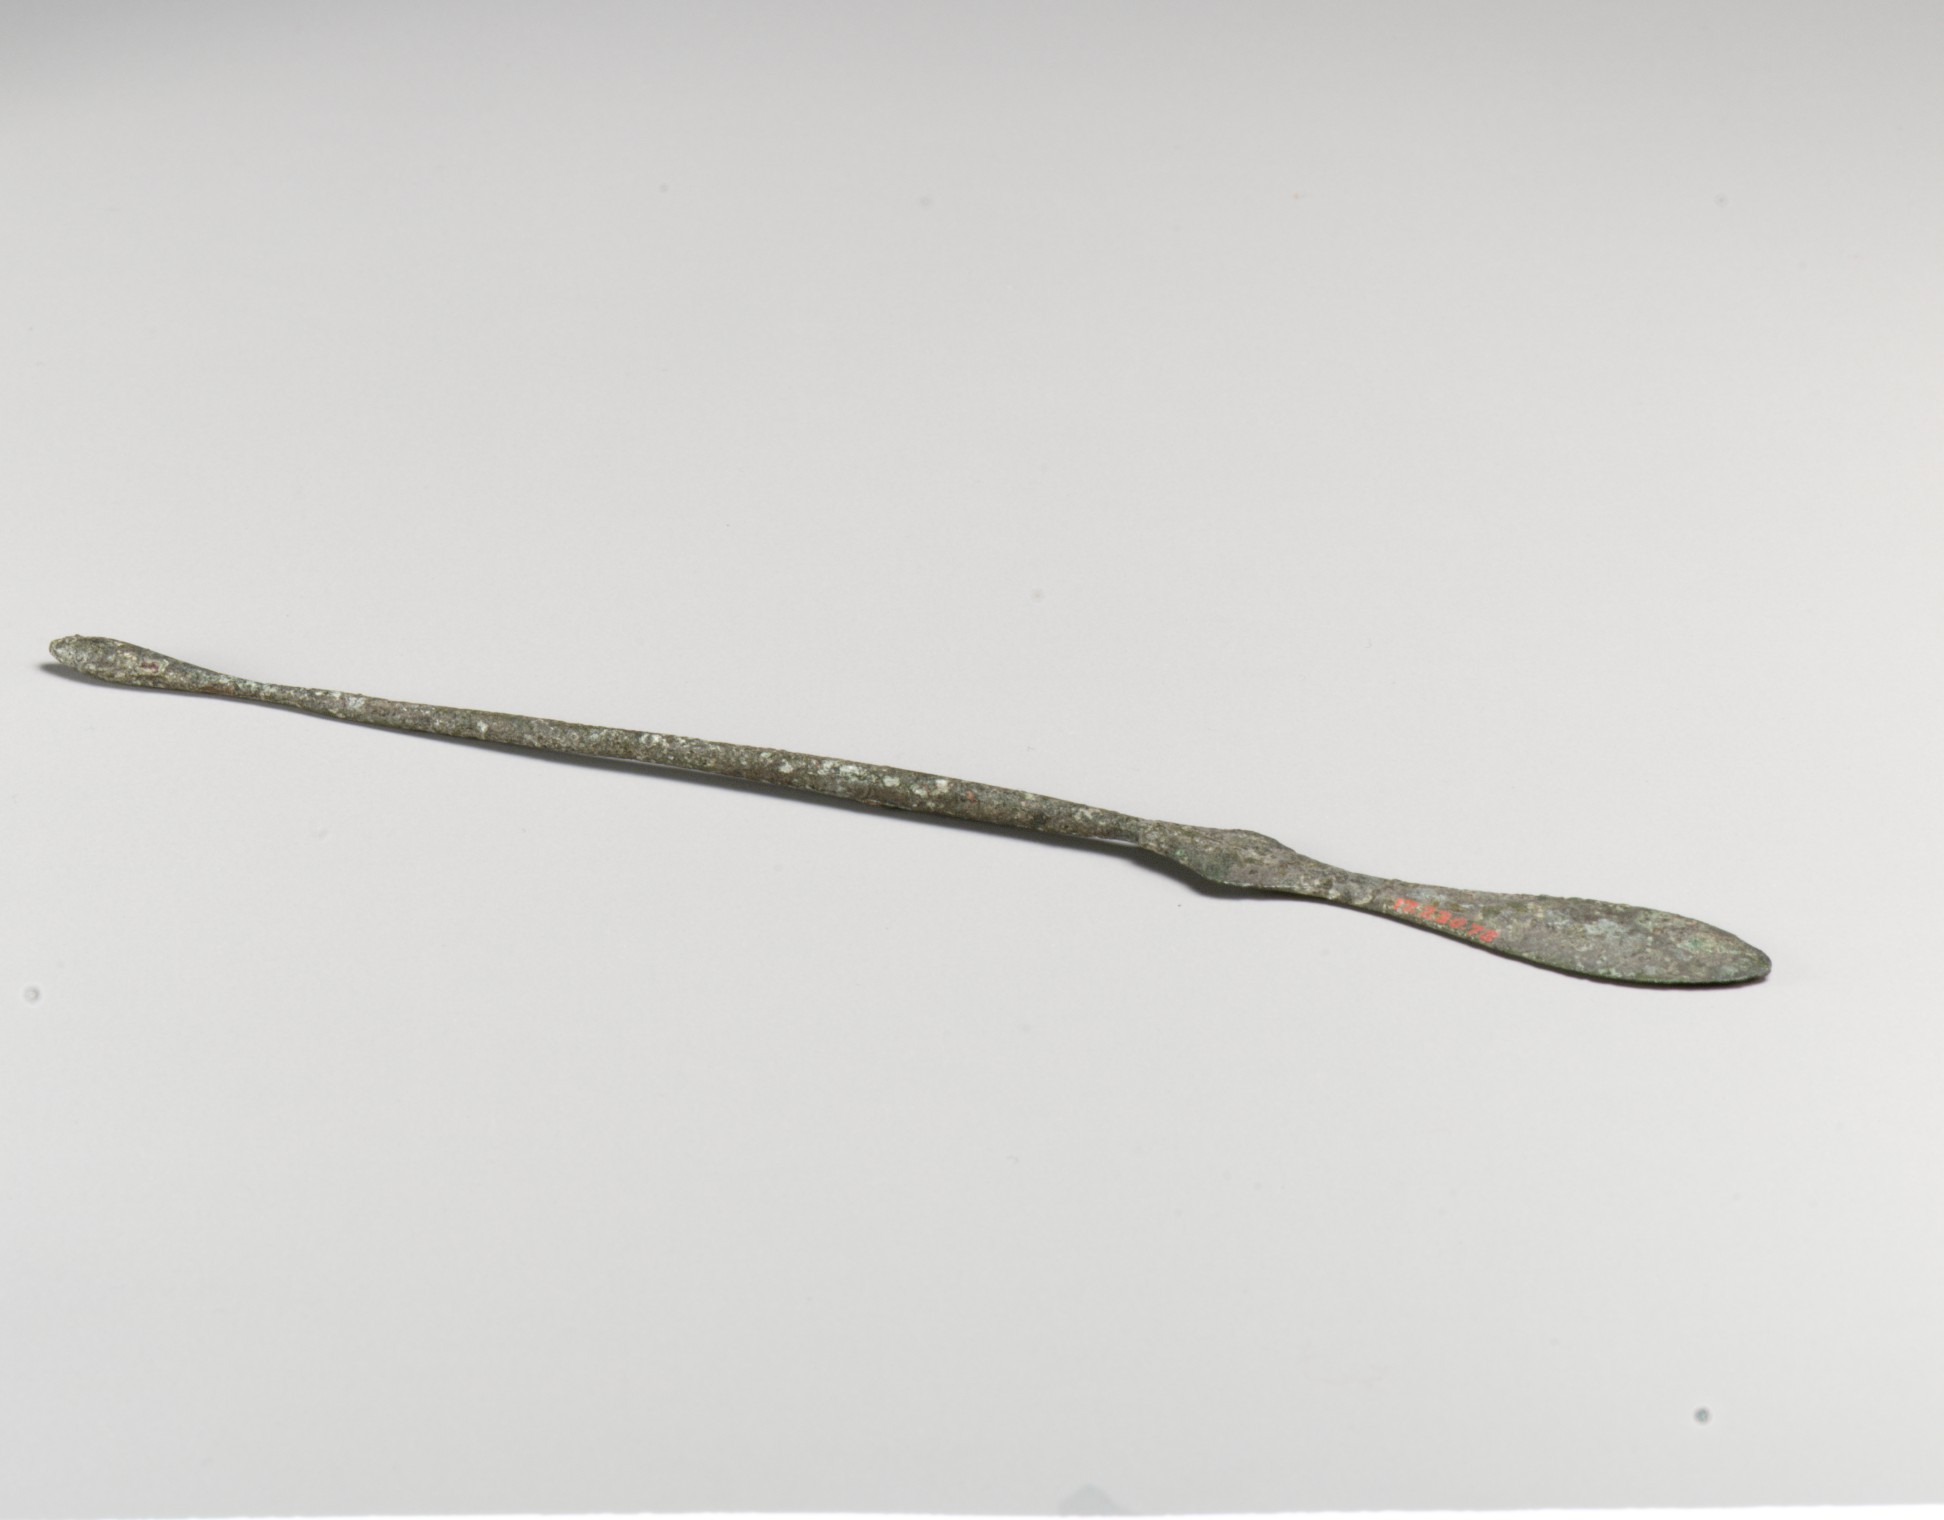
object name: spatula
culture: roman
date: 670 BCE-330 CE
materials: bronze